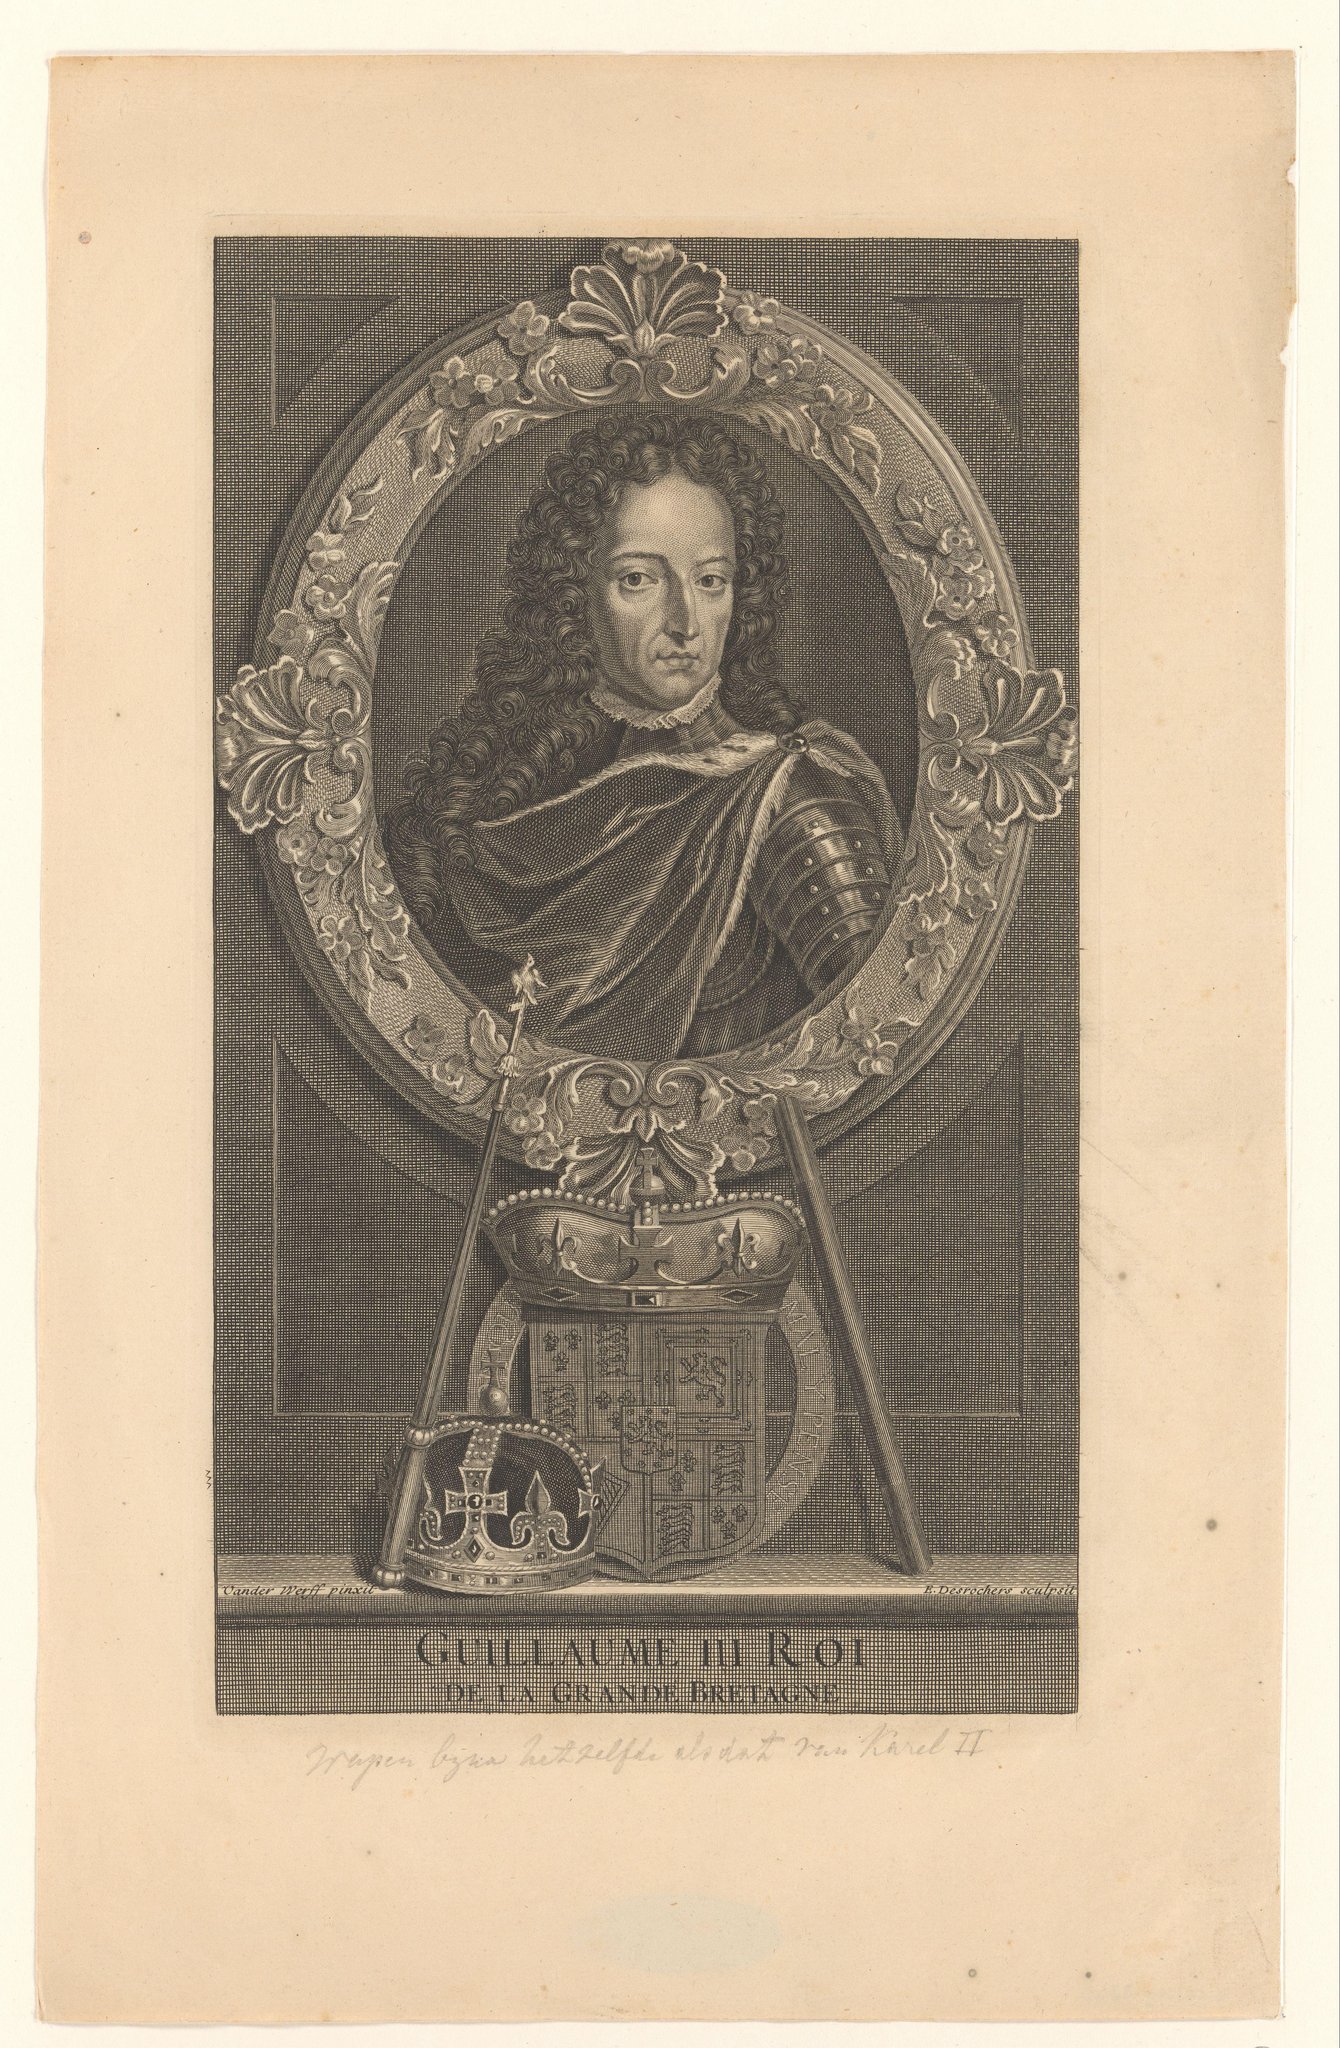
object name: print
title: Portret van Willem III, prins van Oranje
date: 1688-1741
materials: paper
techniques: engraving, etching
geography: paris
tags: william iii (prince of orange and king of england, scotland, and ireland), knighthood order (garter) - insignia of a knighthood order, e.g.: badge, chain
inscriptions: stamp: ‘MUSEUM WILLEM TWEE. A.J. VAN TETROODE, 'S GRAVENHAGE.’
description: Portret van Willem III in een geornamenteerd ovaal. Midden onder zijn wapen met een kroon, gedecoreerd met de Kousenband en het devies van de Orde van de Kousenband. Rondom ligt een aantal allegorische objecten. Op een voetstuk zijn naam en titel in het Frans.